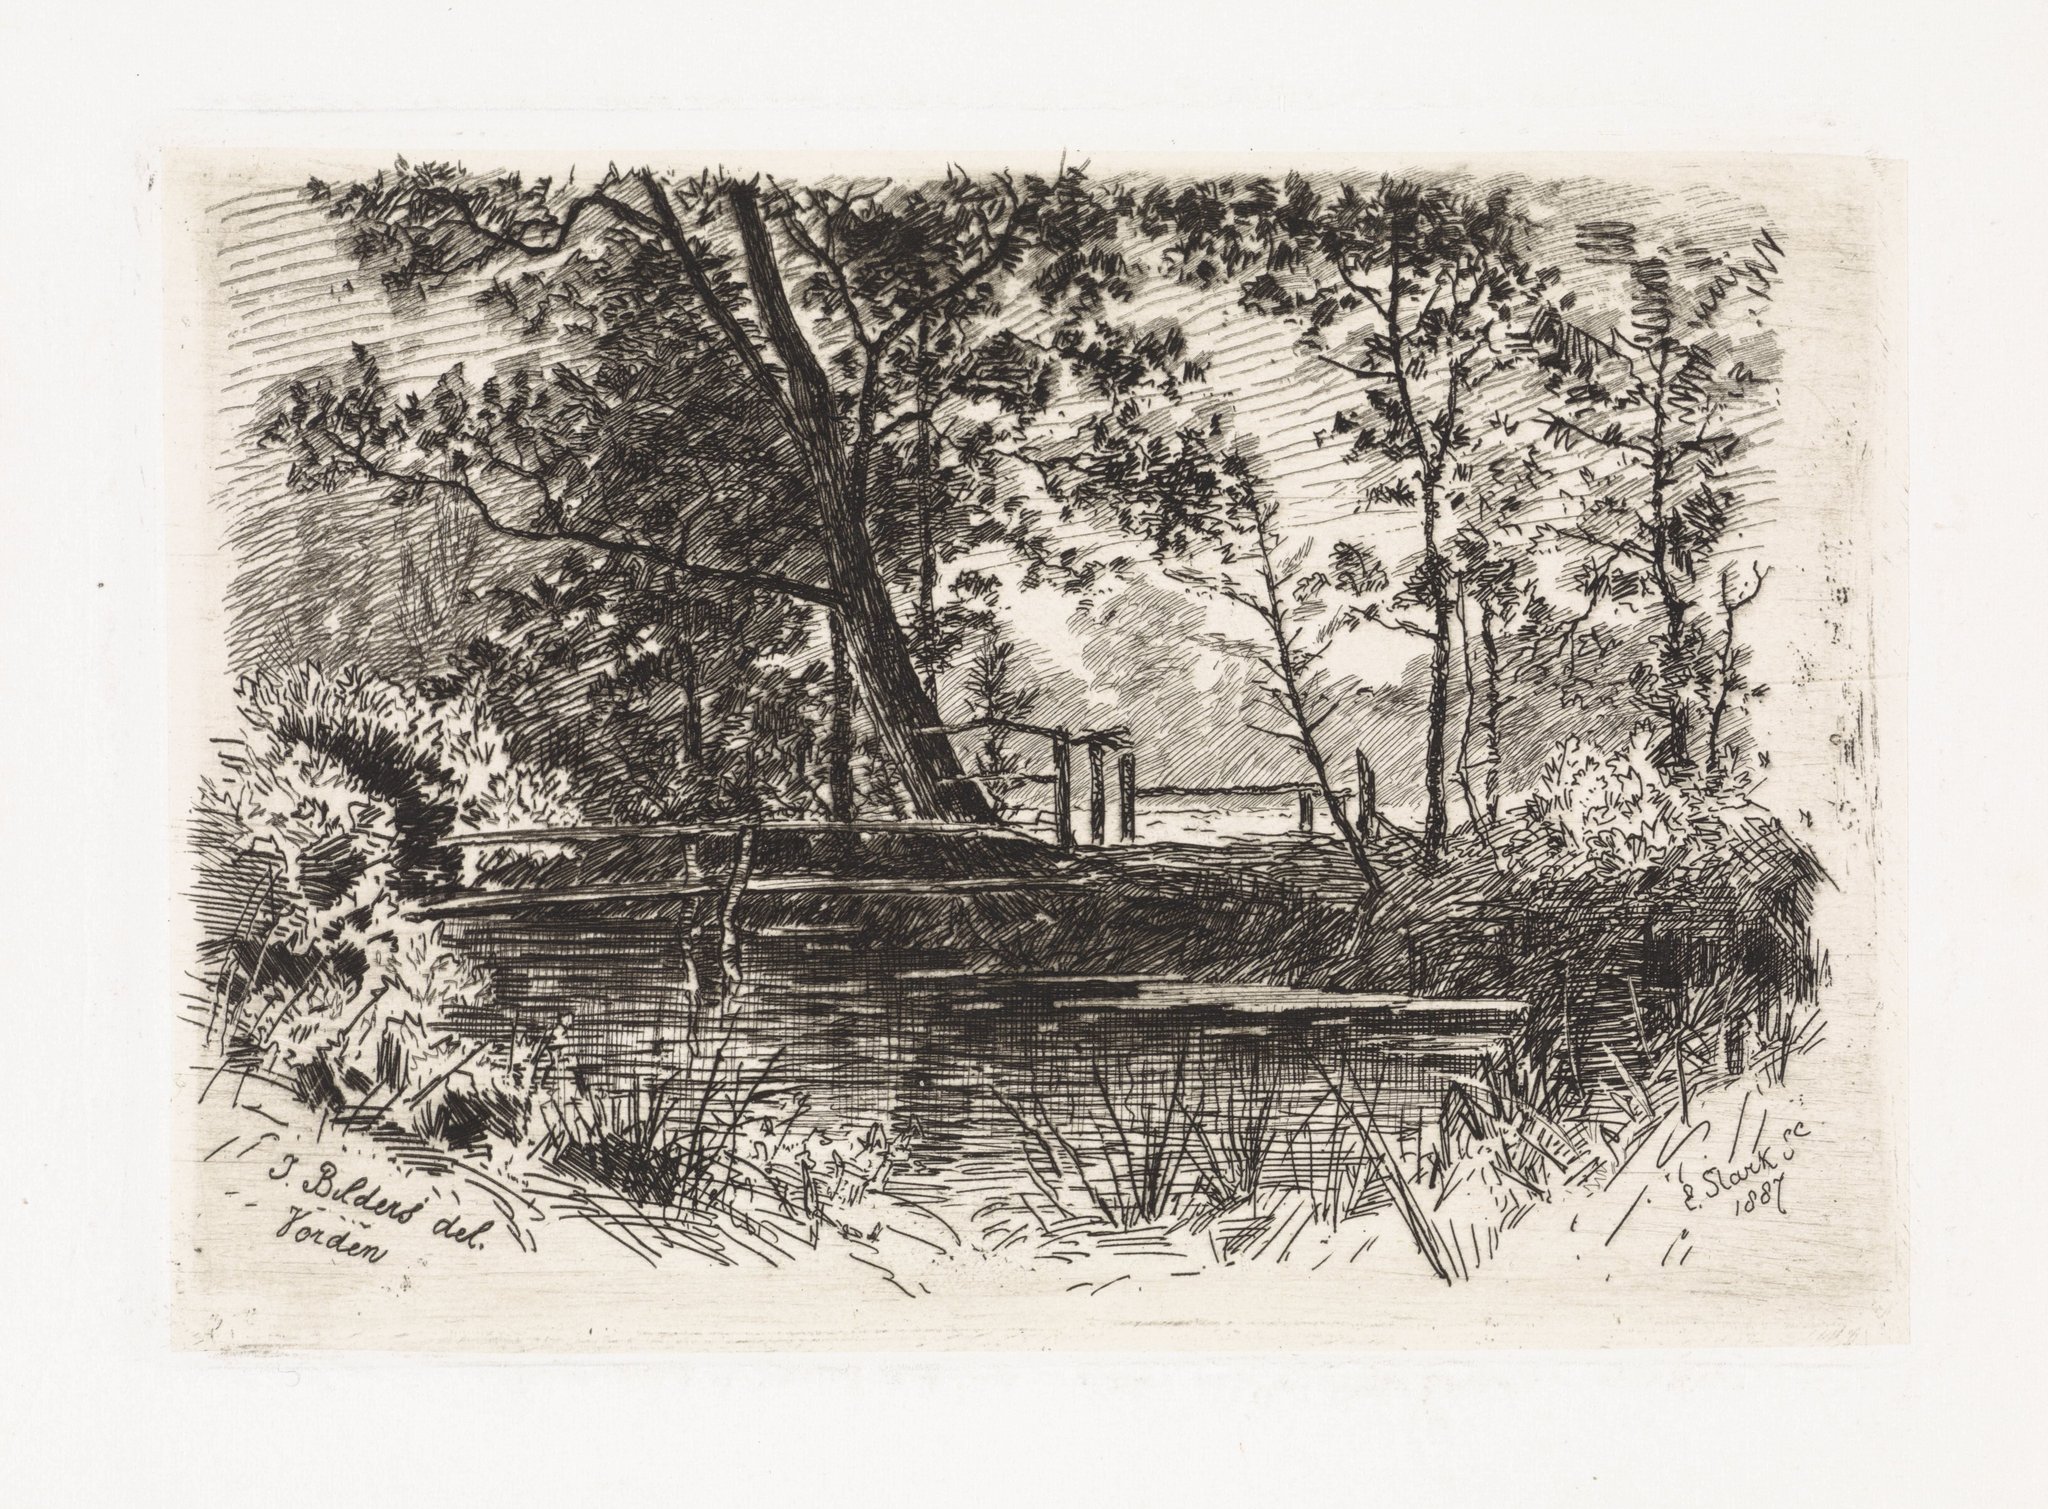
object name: print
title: Landschap met sloot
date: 1887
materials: paper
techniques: etching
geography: vorden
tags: trees, water course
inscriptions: collector's mark: Lugt 2228